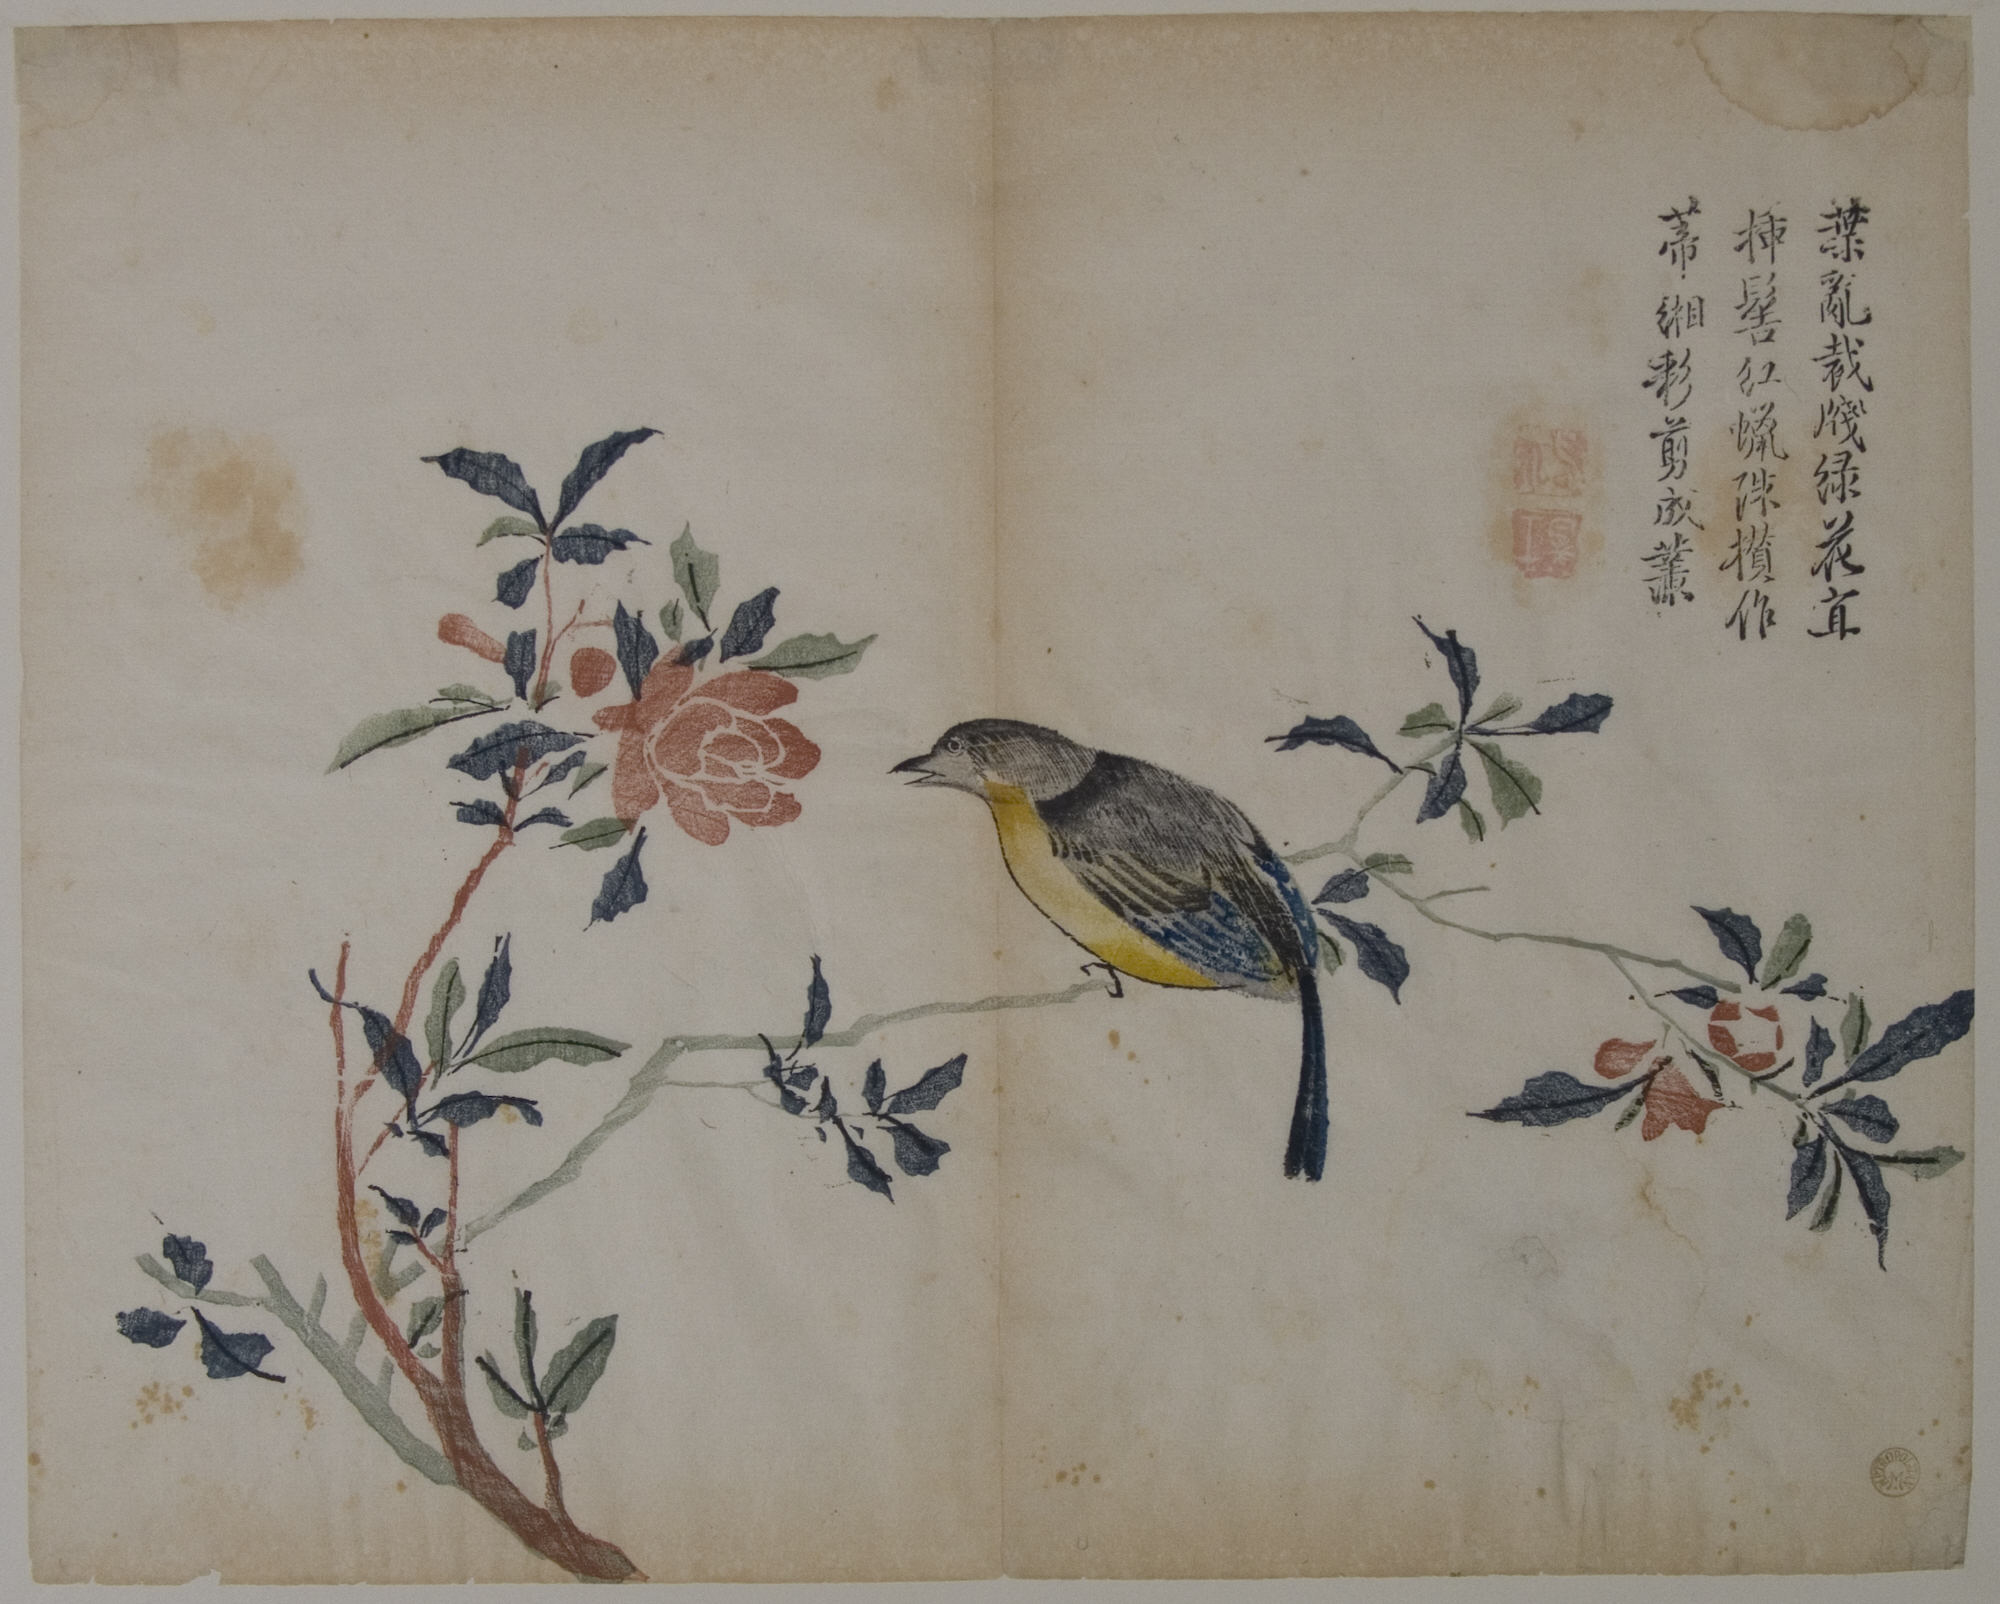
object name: print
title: Bird on a Flowering Branch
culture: chinese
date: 1801-1900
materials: ink, paper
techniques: polychrome, woodblock print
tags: birds,trees